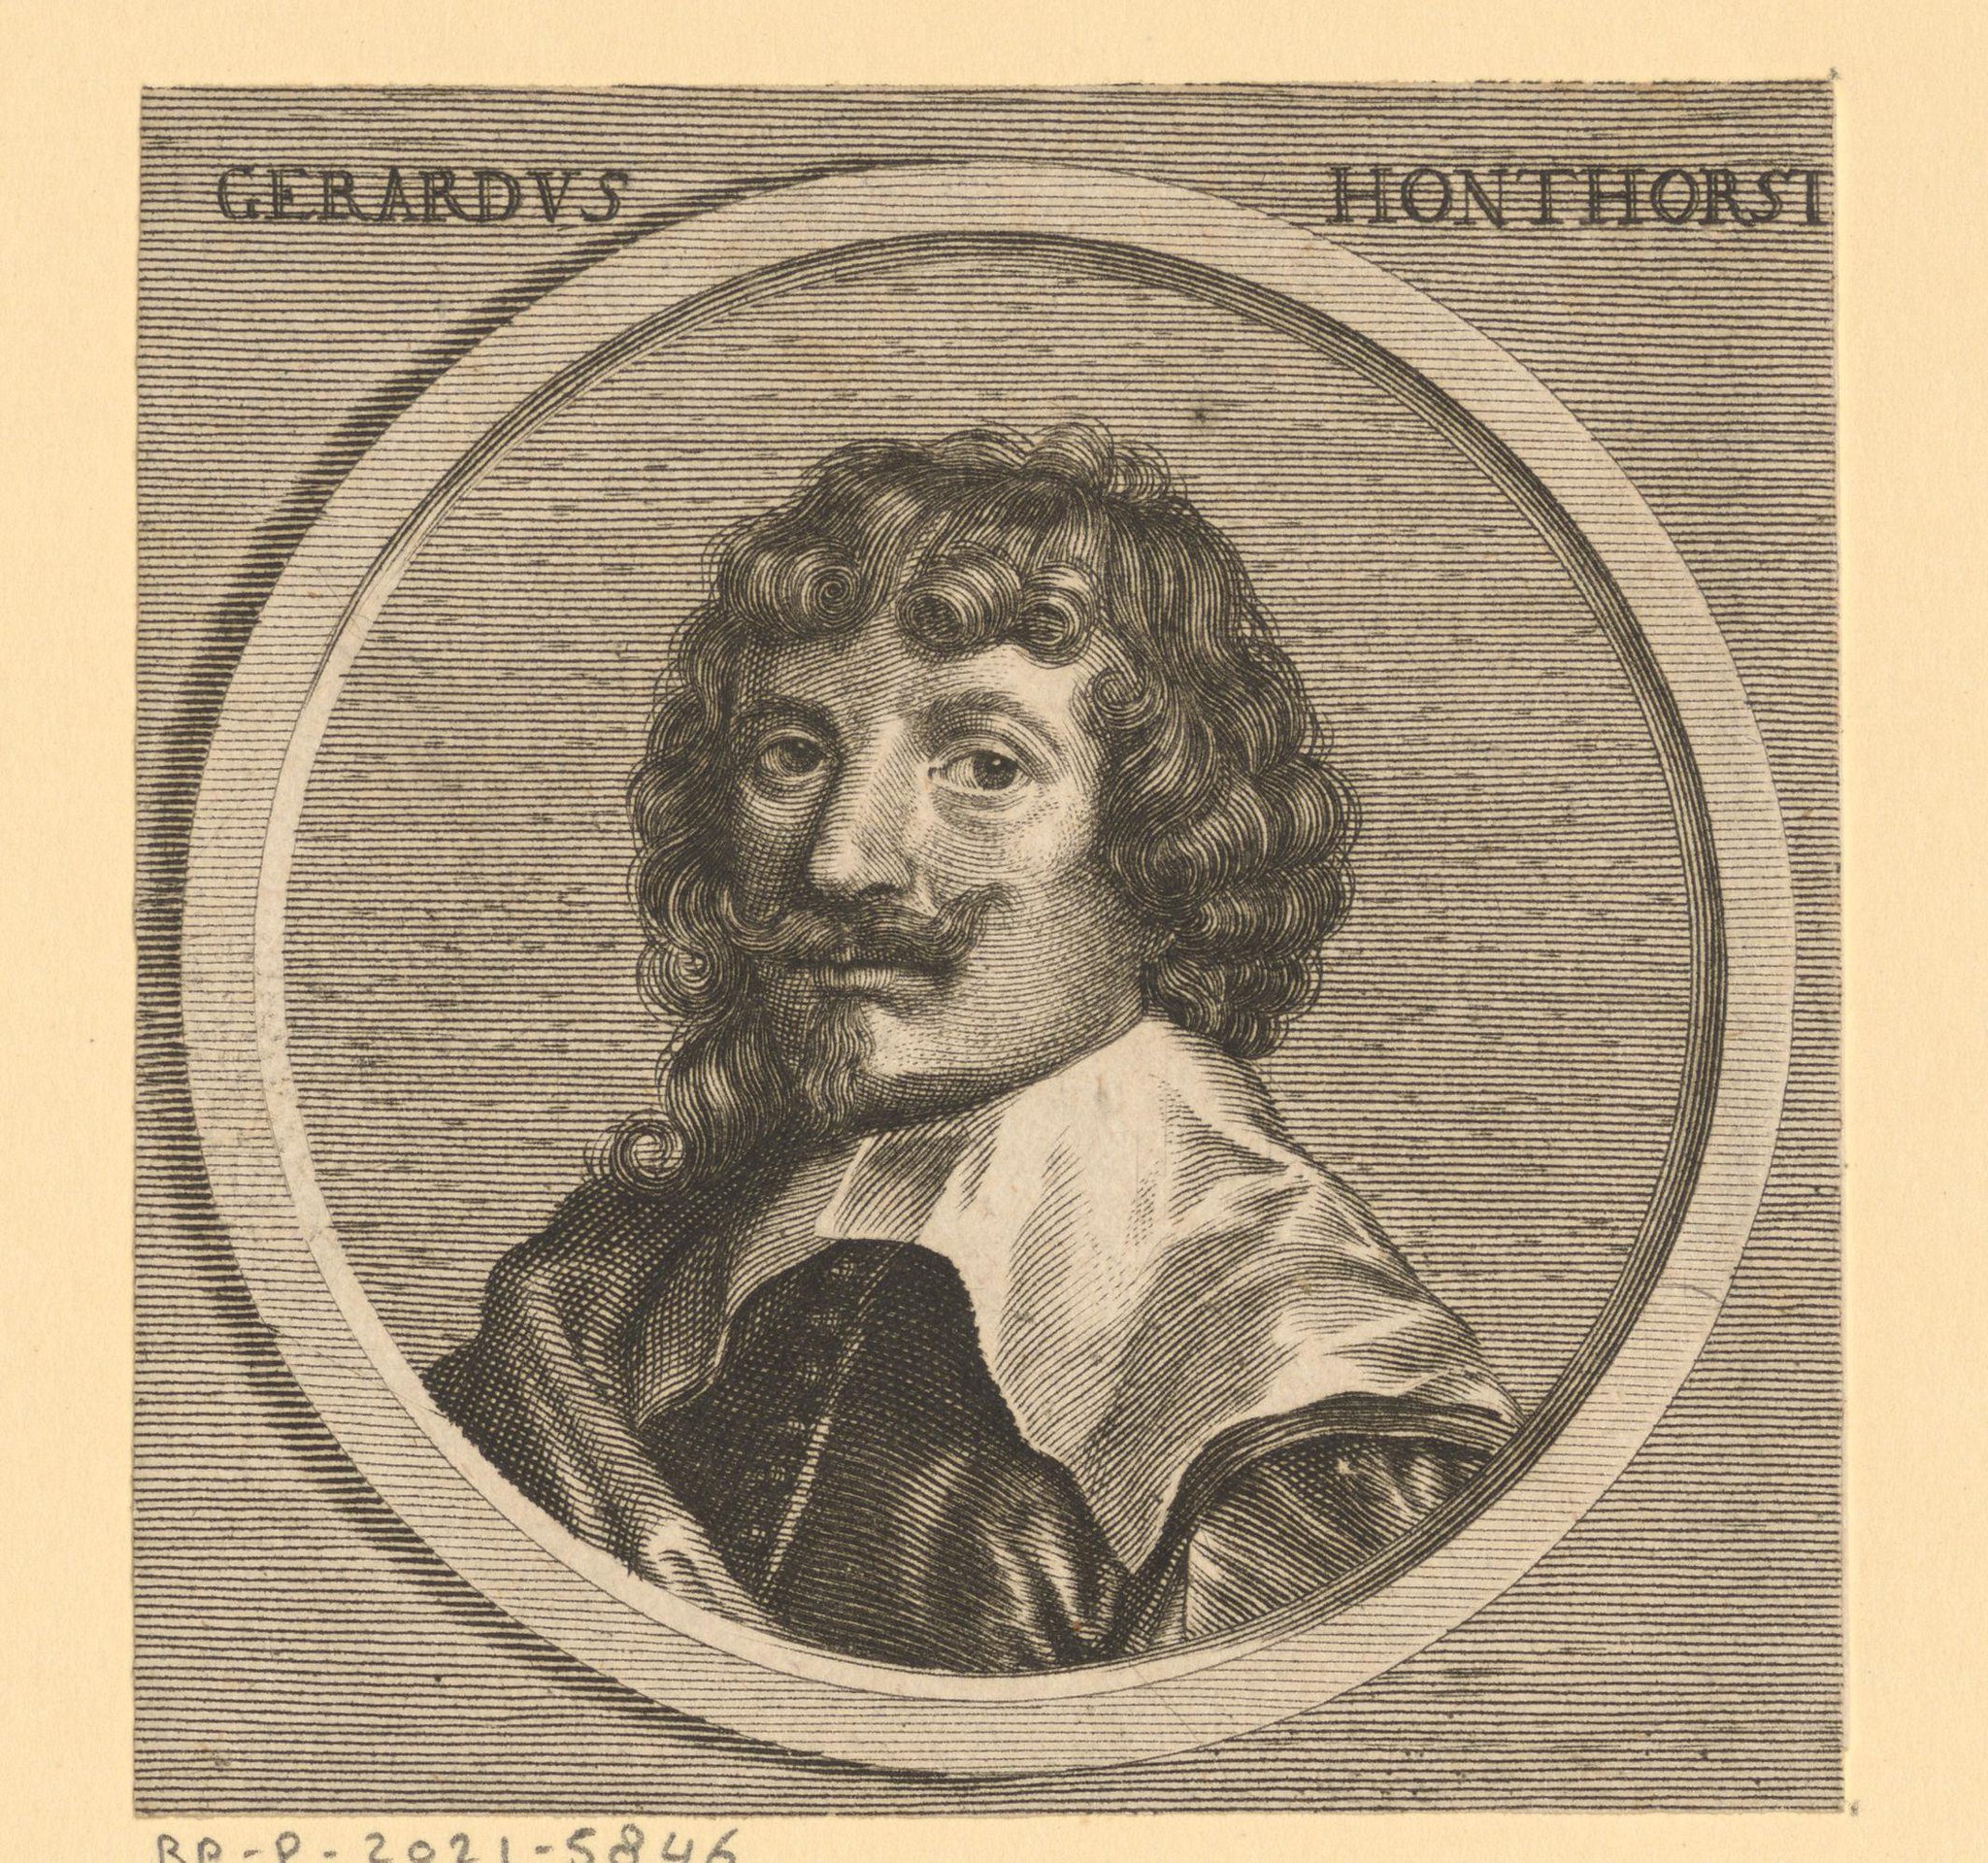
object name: print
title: Portret van Gerard van Honthorst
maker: Anonymous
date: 1675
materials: paper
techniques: engraving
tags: utrecht, painter, print maker, draughtsman, gerard van honthorst, historical persons, portrait, self-portrait of painter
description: Prent voor het eerst verschenen in: Sandrart, Joachim von. Der Teutschen Academie (...). Neurenberg: Johann Philipp Miltenberger, 1675. Prent ook gebruikt in latere edities van dit werk.